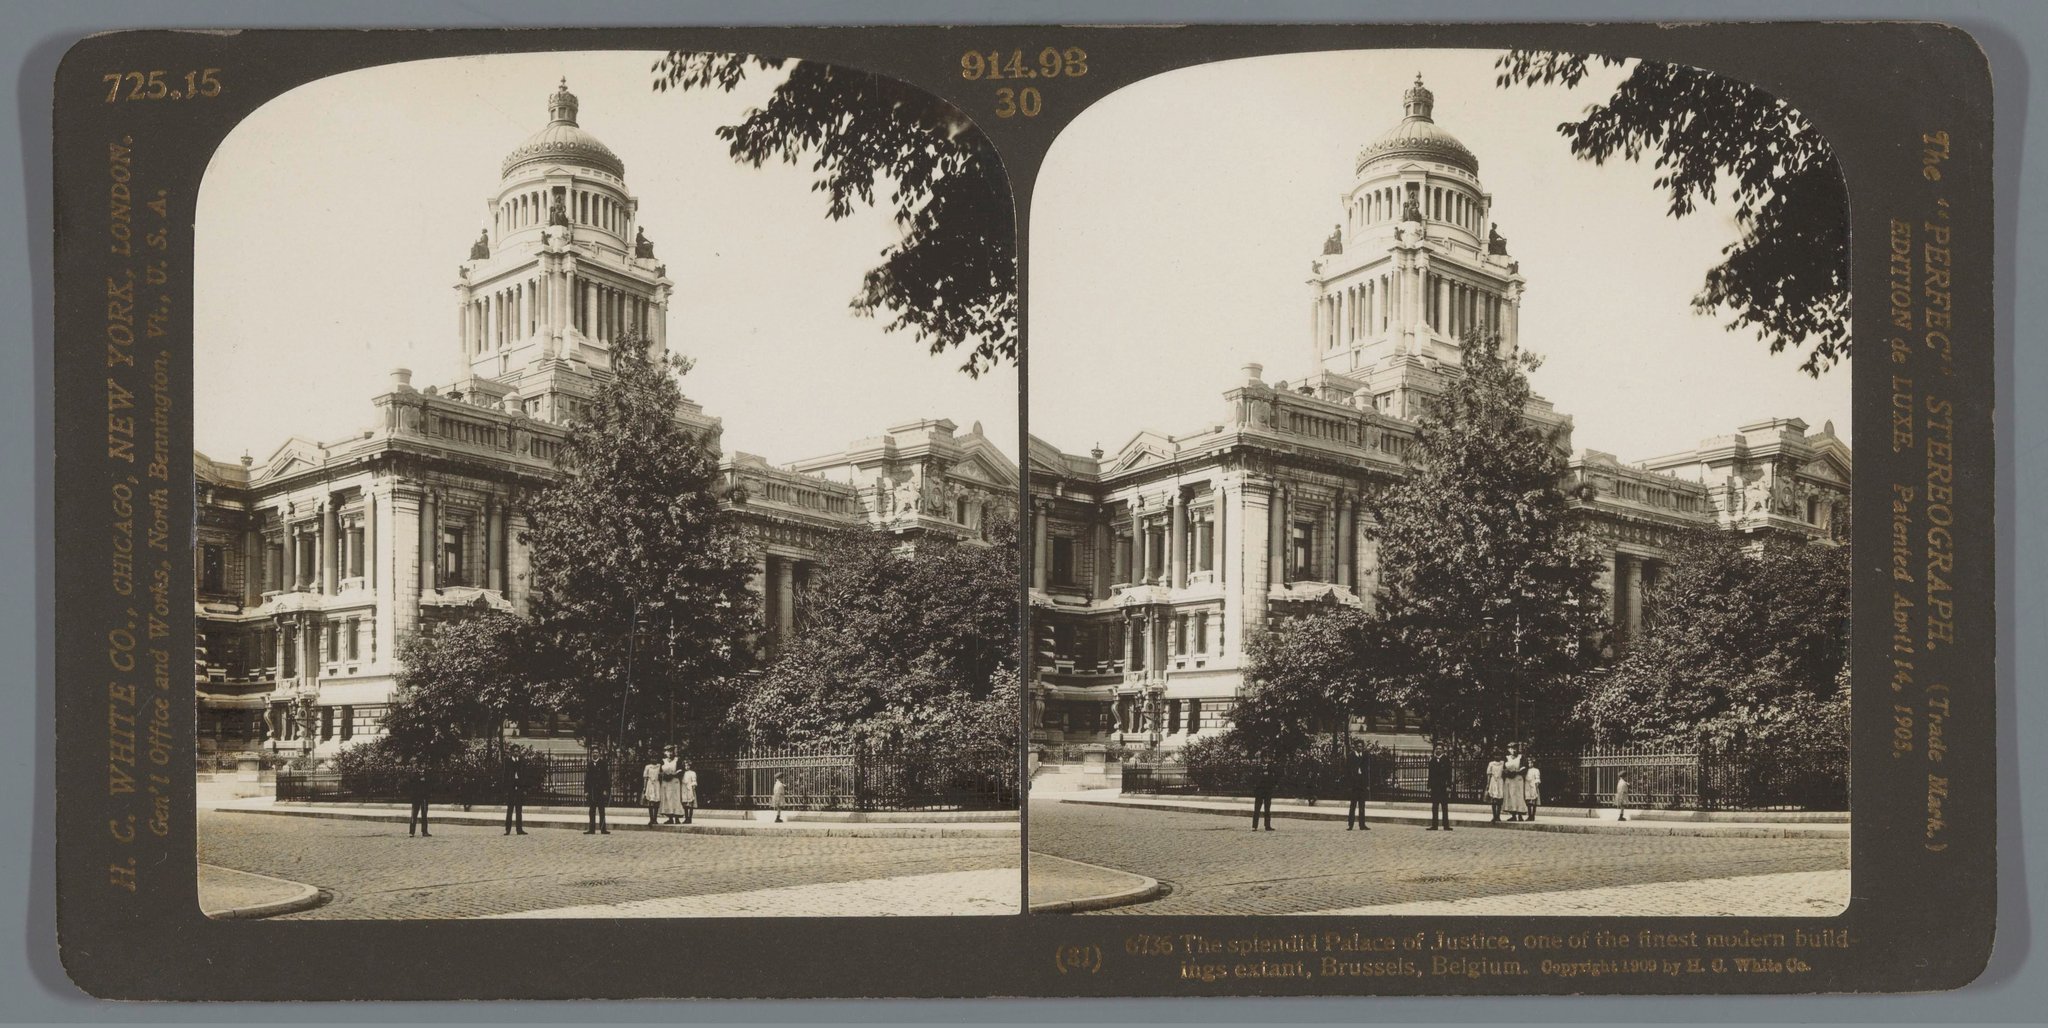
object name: stereograph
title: The splendid Palace of Justice, one of the finest modern buildings extant, Brussels, Belgium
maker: Anonymous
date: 1909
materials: cardboard, photographic support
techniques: gelatin silver print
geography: new york city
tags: court building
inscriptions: inscription: ‘All Perfec-Stereograph subjects may be secured in Lantern Slides and Enlargements.’, copyright notice: ‘Copyright 1909 by H. C. White Co.’, inscription: ‘4.’, inscription: ‘Juli - Augustus 1910’, number: ‘6737’, number: ‘725.15’, number: ‘(31) ’, inscription: ‘The " PERFEC" STEREOGRAPH. (Trade Mark.)/ EDITION de LUXE. Patented April 14, 1903.’, number: ‘914.93/ 30 ’